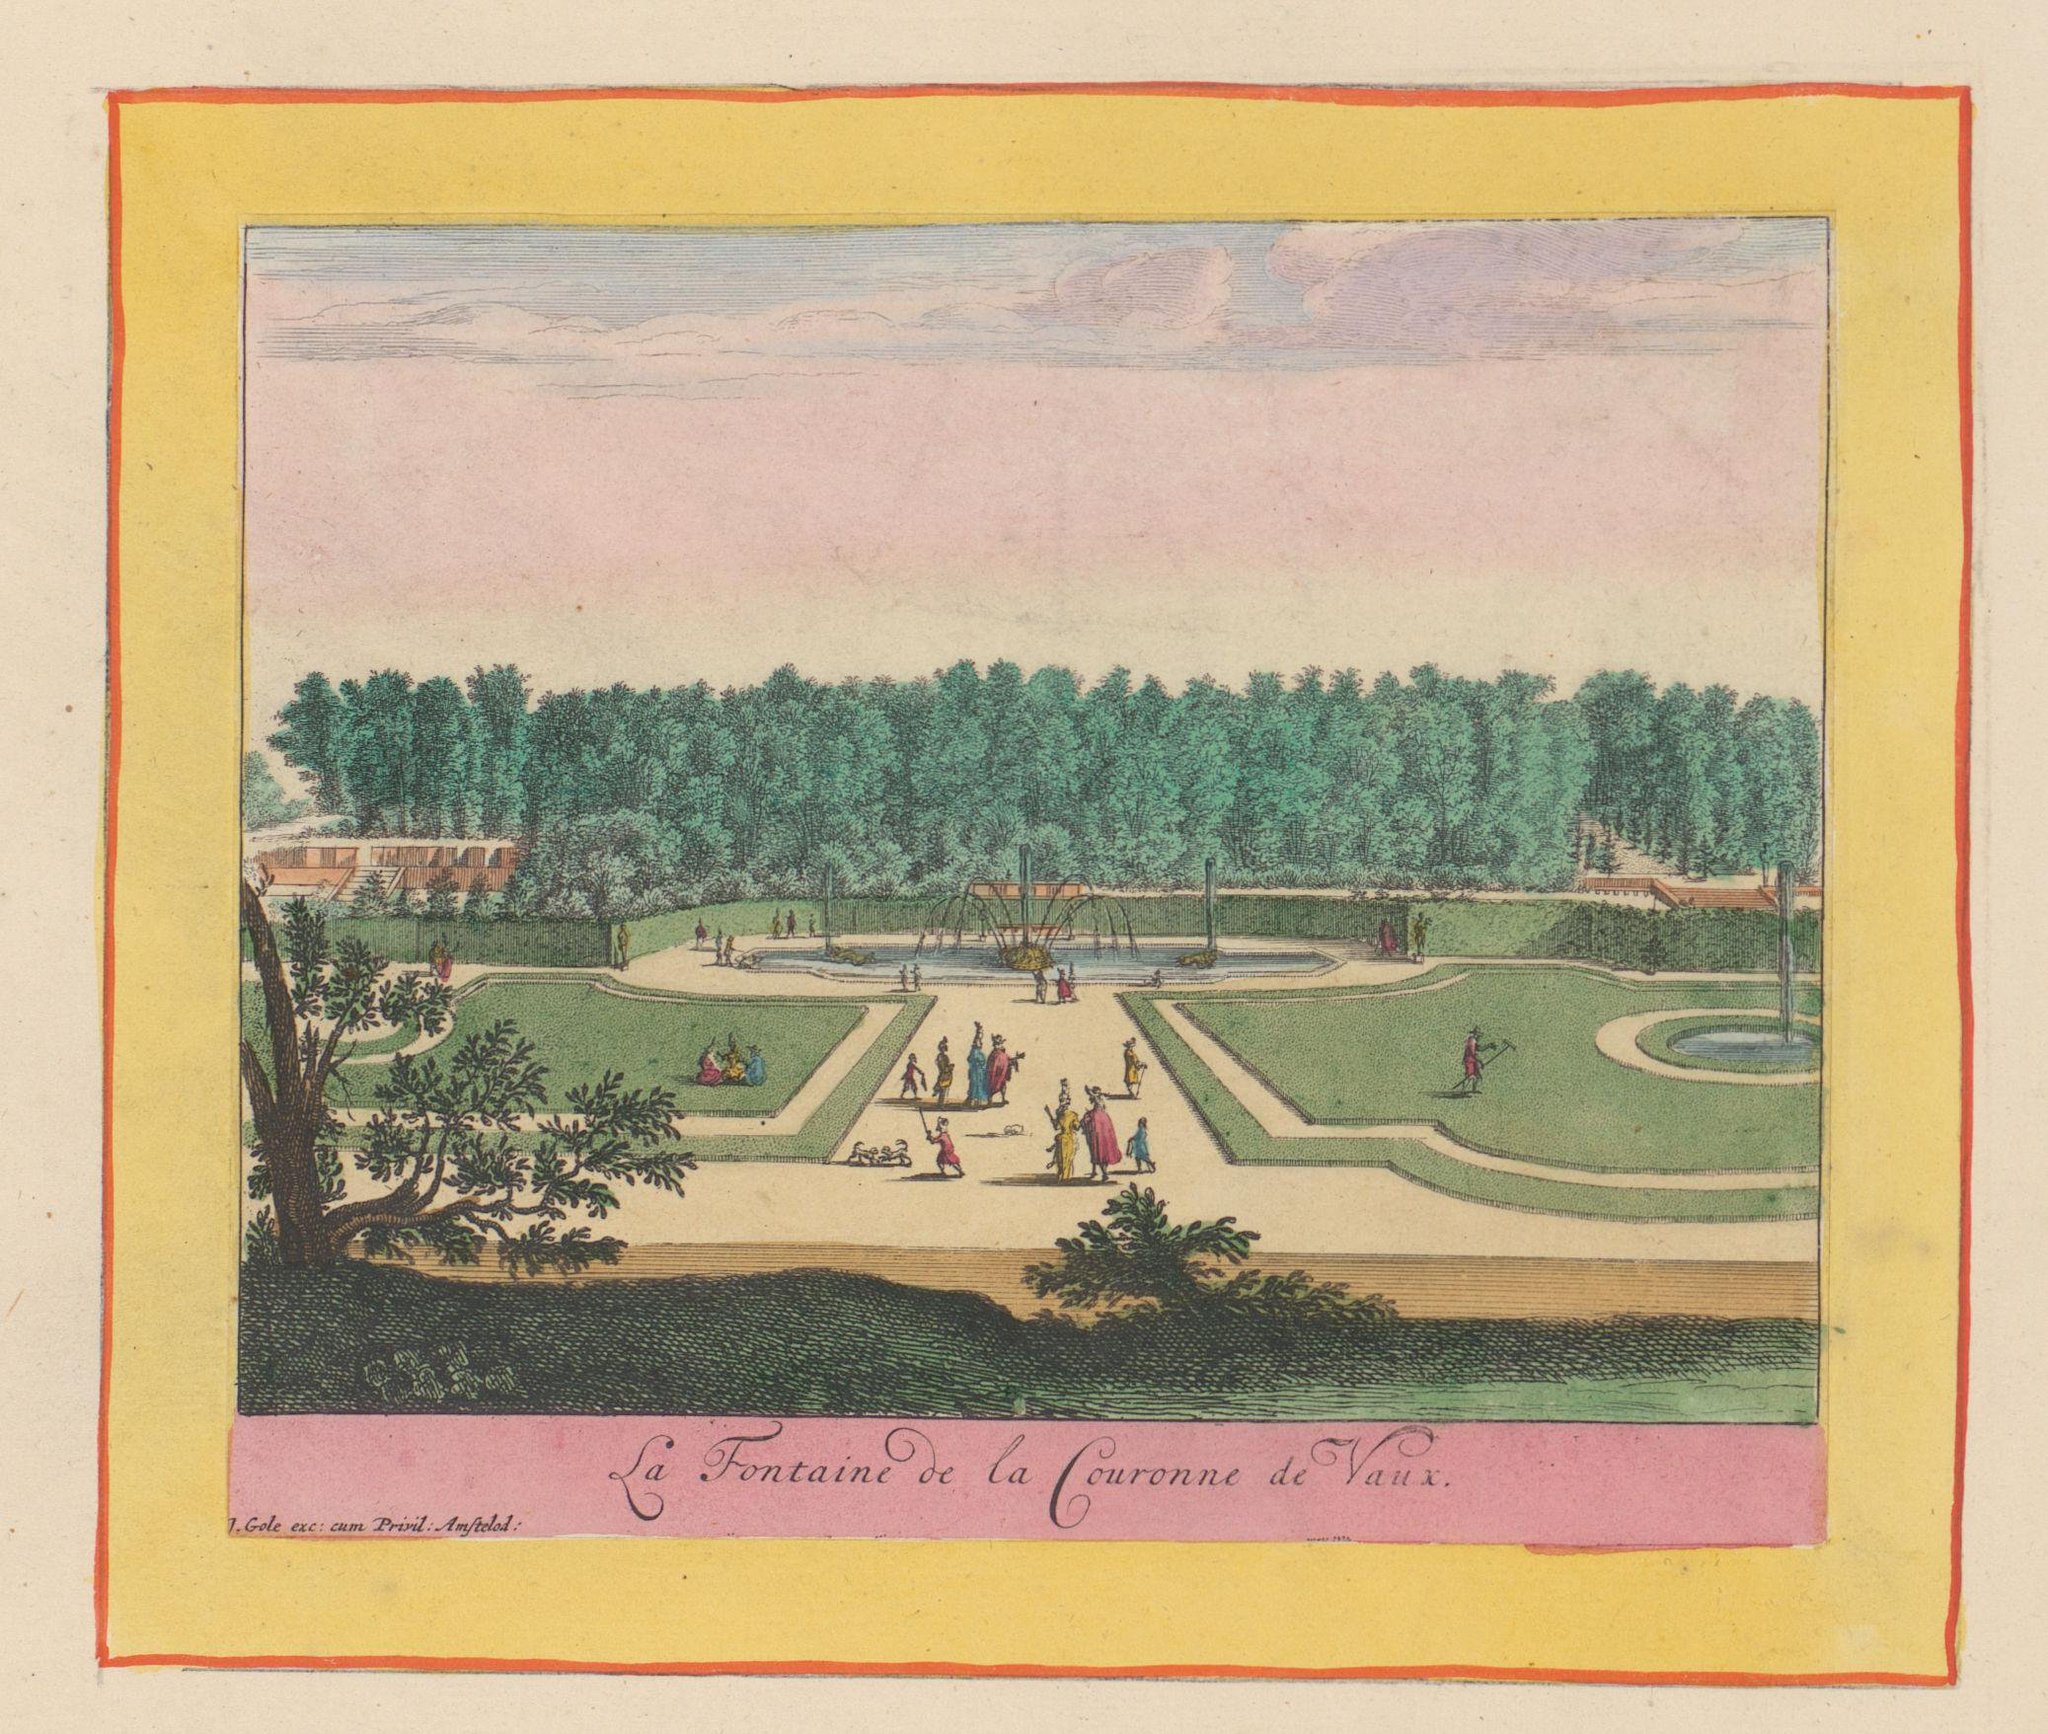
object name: print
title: Gezichten op Château de Vaux-le-Vicomte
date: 1681-1724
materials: paper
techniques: etching, hand coloring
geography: the hague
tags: garden fountain, french or architectonic garden; formal garden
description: Gezicht op de kroonfontein in de tuinen van Château de Vaux-le-Vicomte. Prent maakt deel uit van een album.